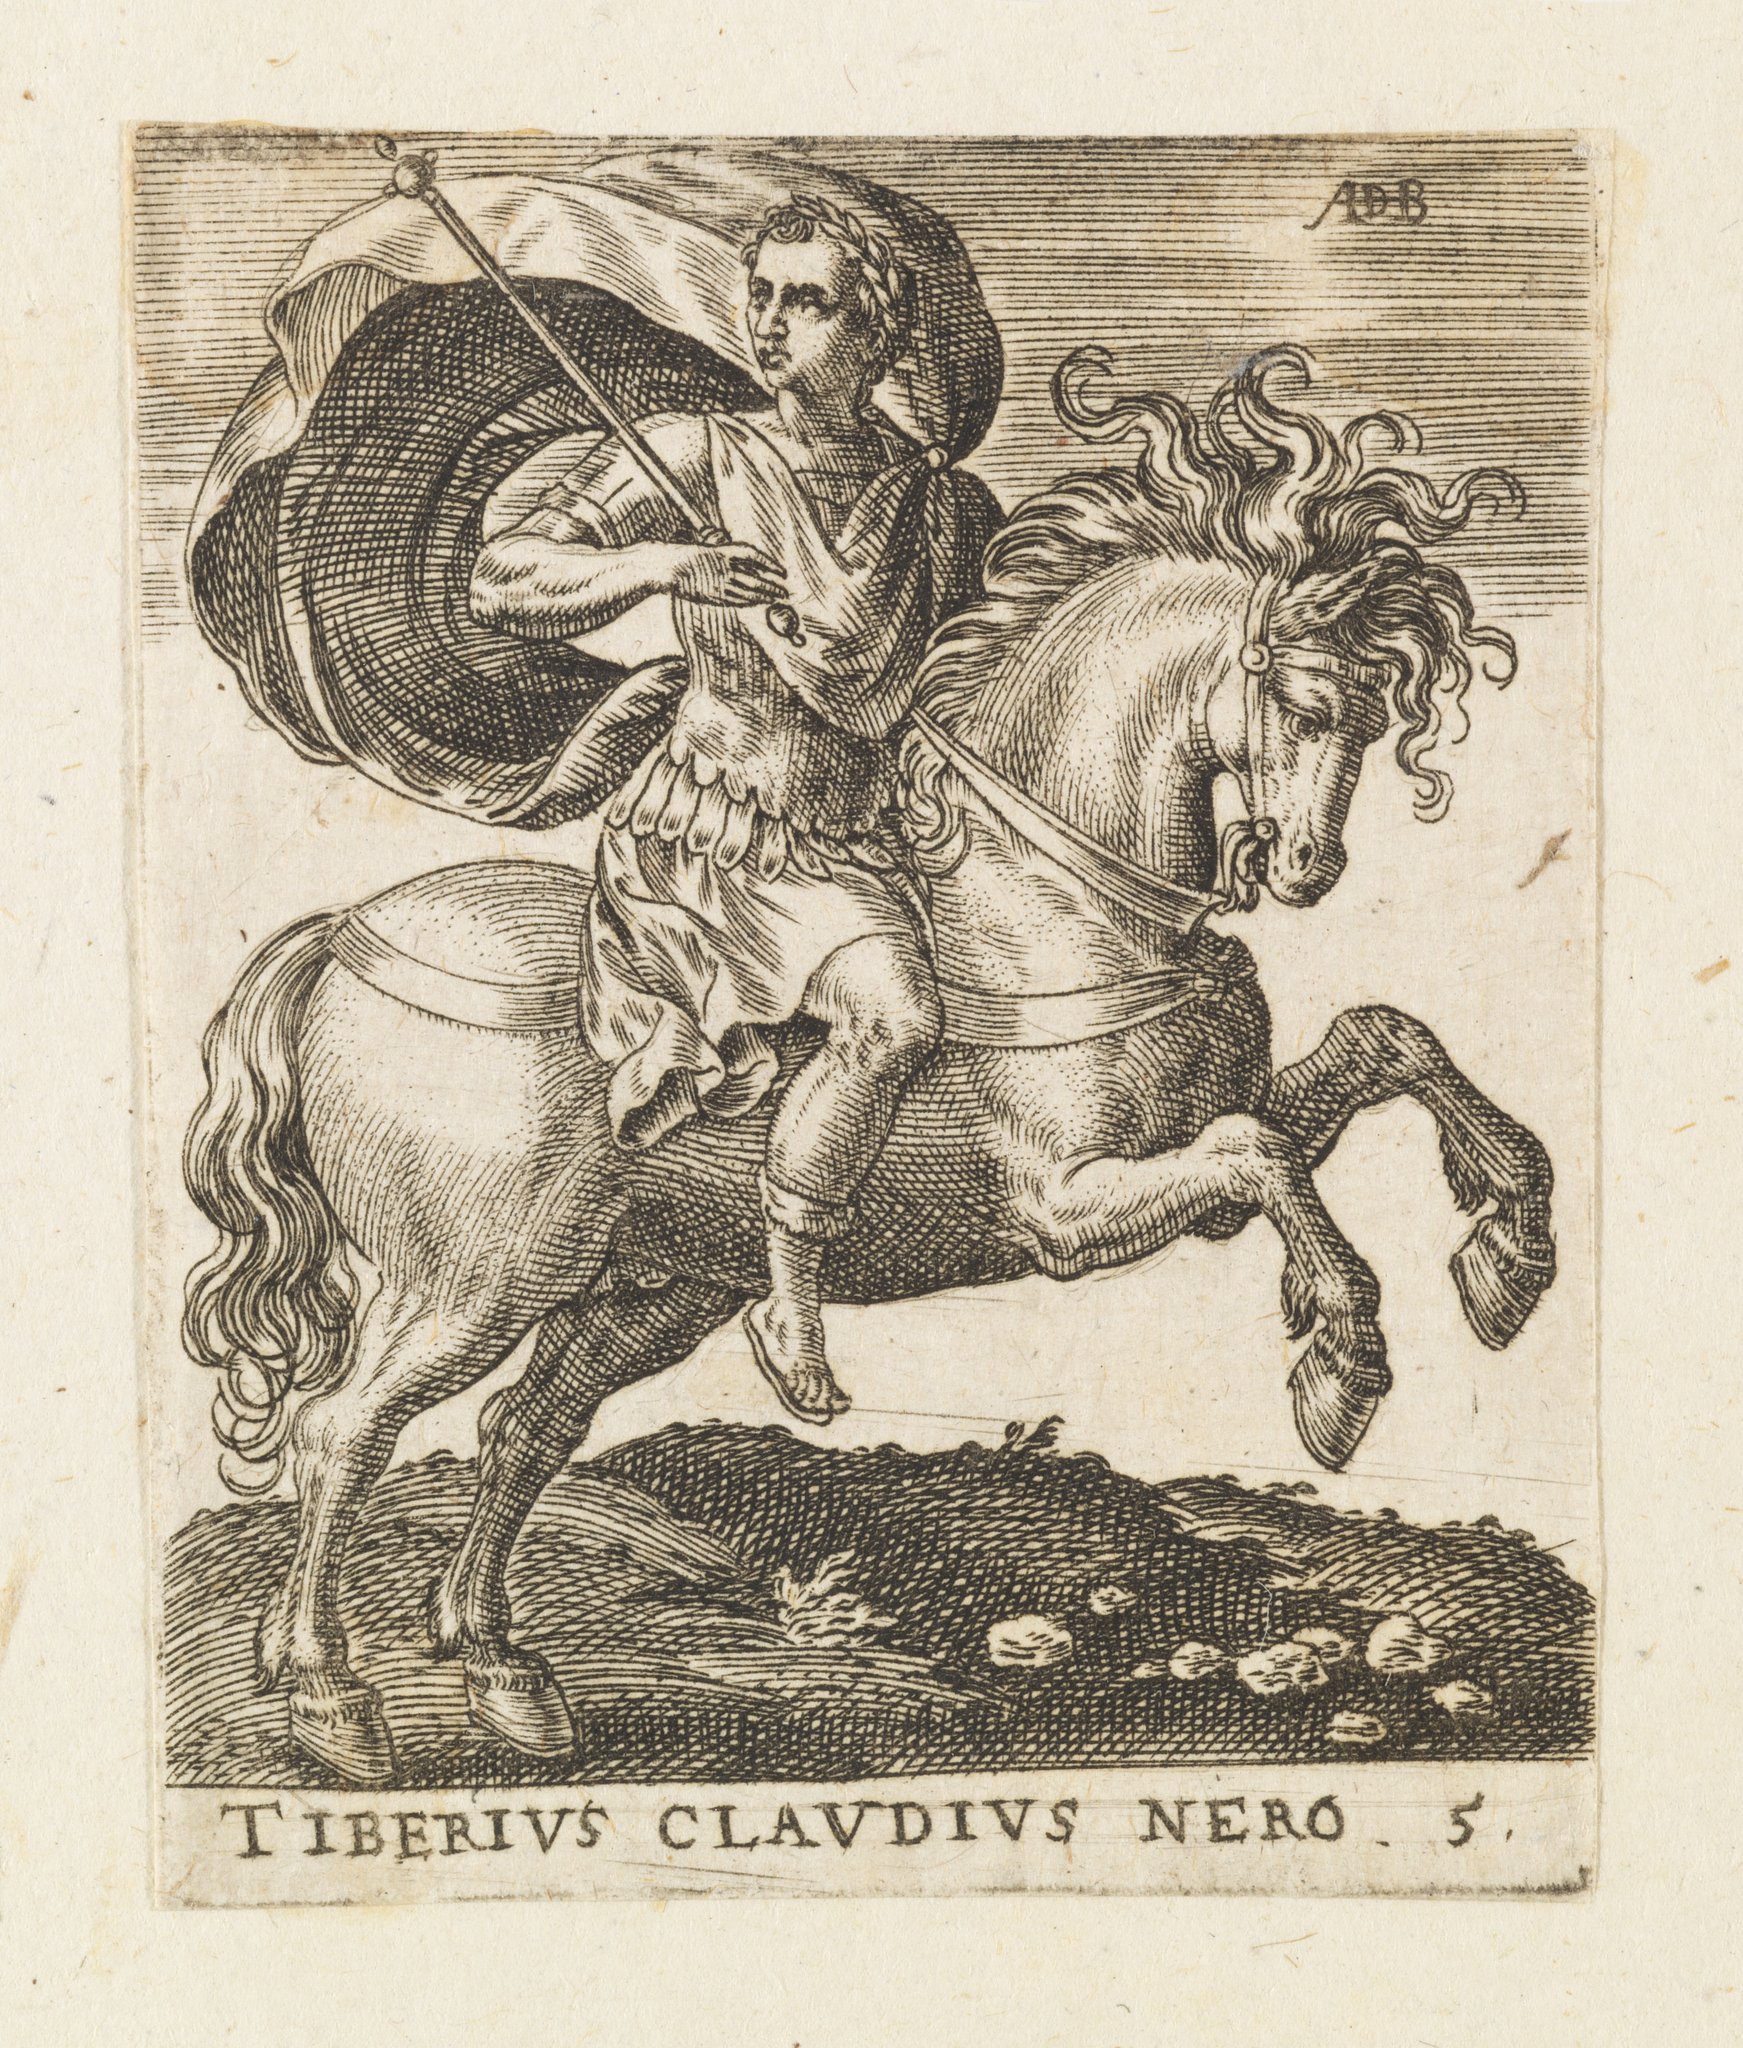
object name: print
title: Tiberius Claudius Nero, from "Twelve Caesars on Horseback"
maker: abraham de bruyn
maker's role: artist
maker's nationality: flemish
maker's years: 1540-1587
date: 1565-1587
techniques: engraving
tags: nero,horses